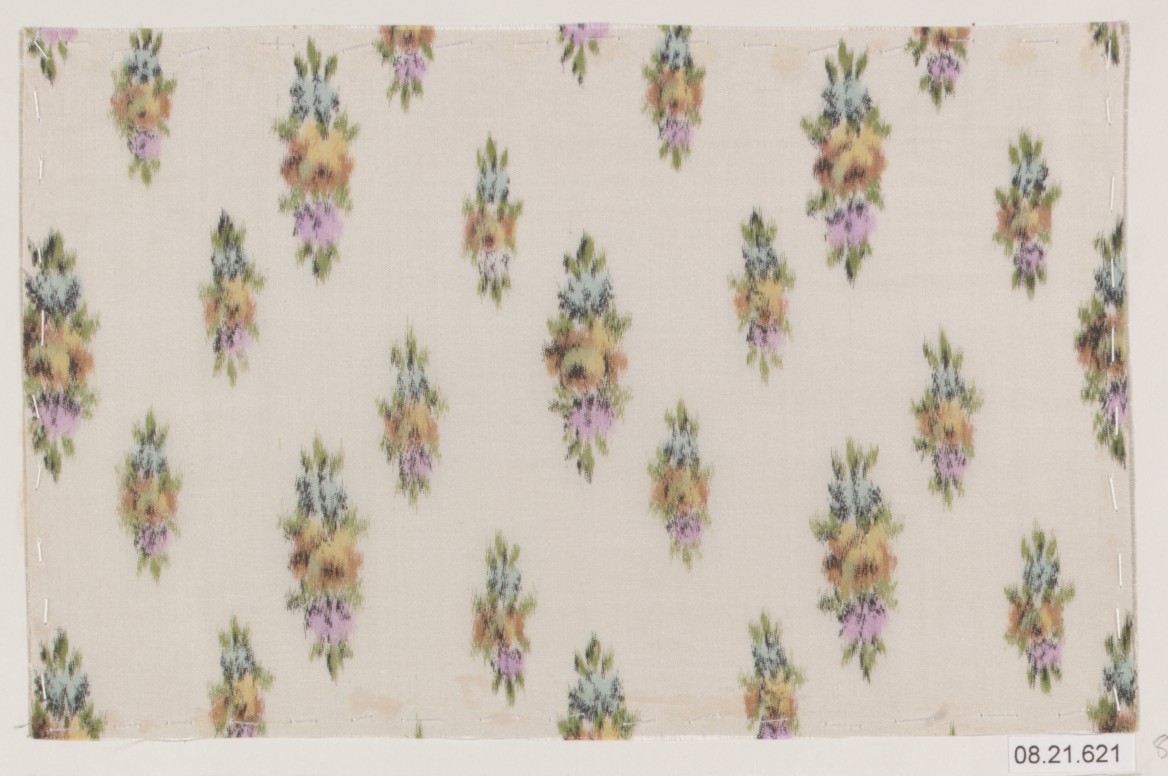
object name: textile sample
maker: Anonymous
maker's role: designer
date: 1900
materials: silk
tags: flowers